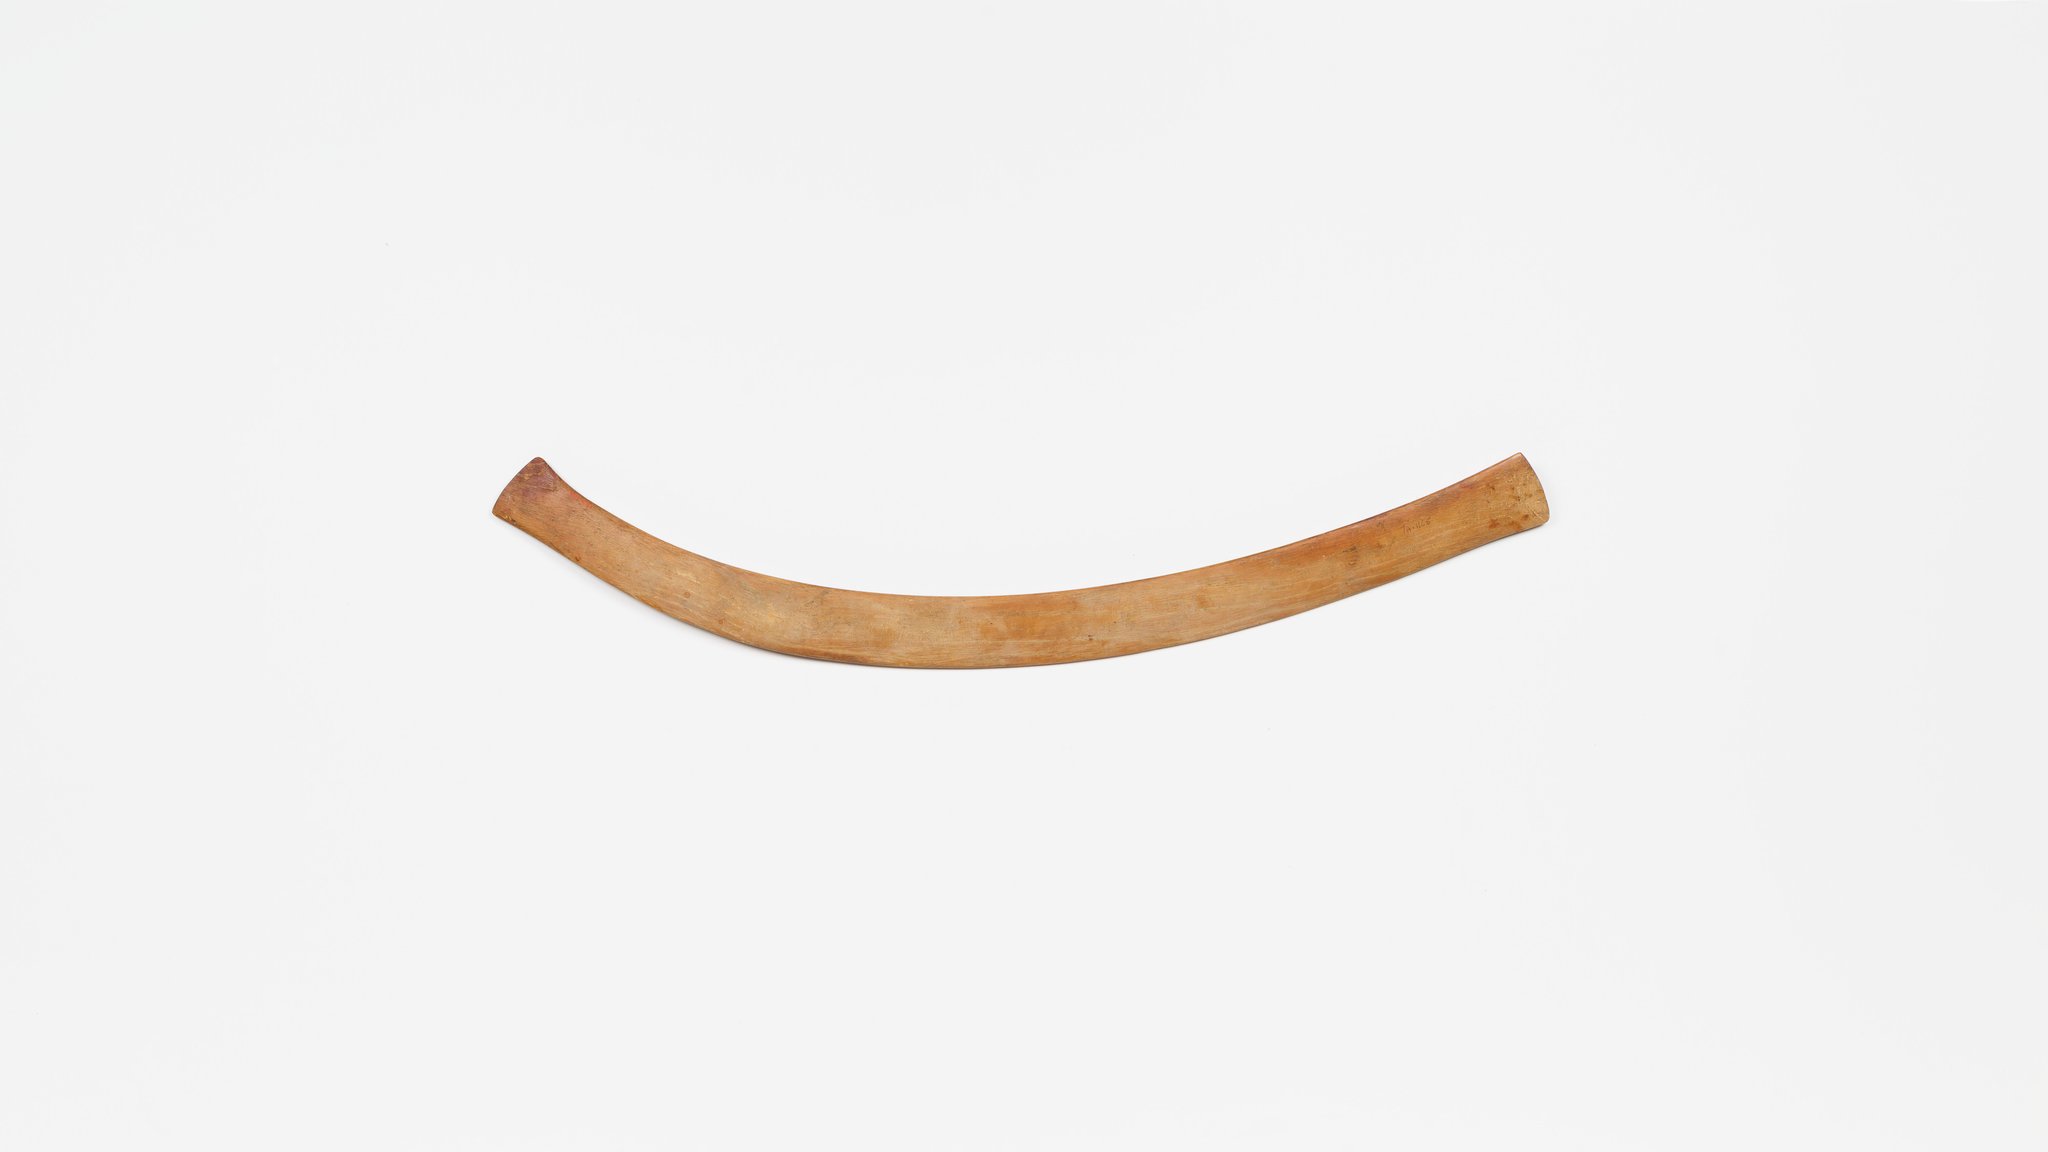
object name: boomerang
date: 1640-1550 BCE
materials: wood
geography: egypt